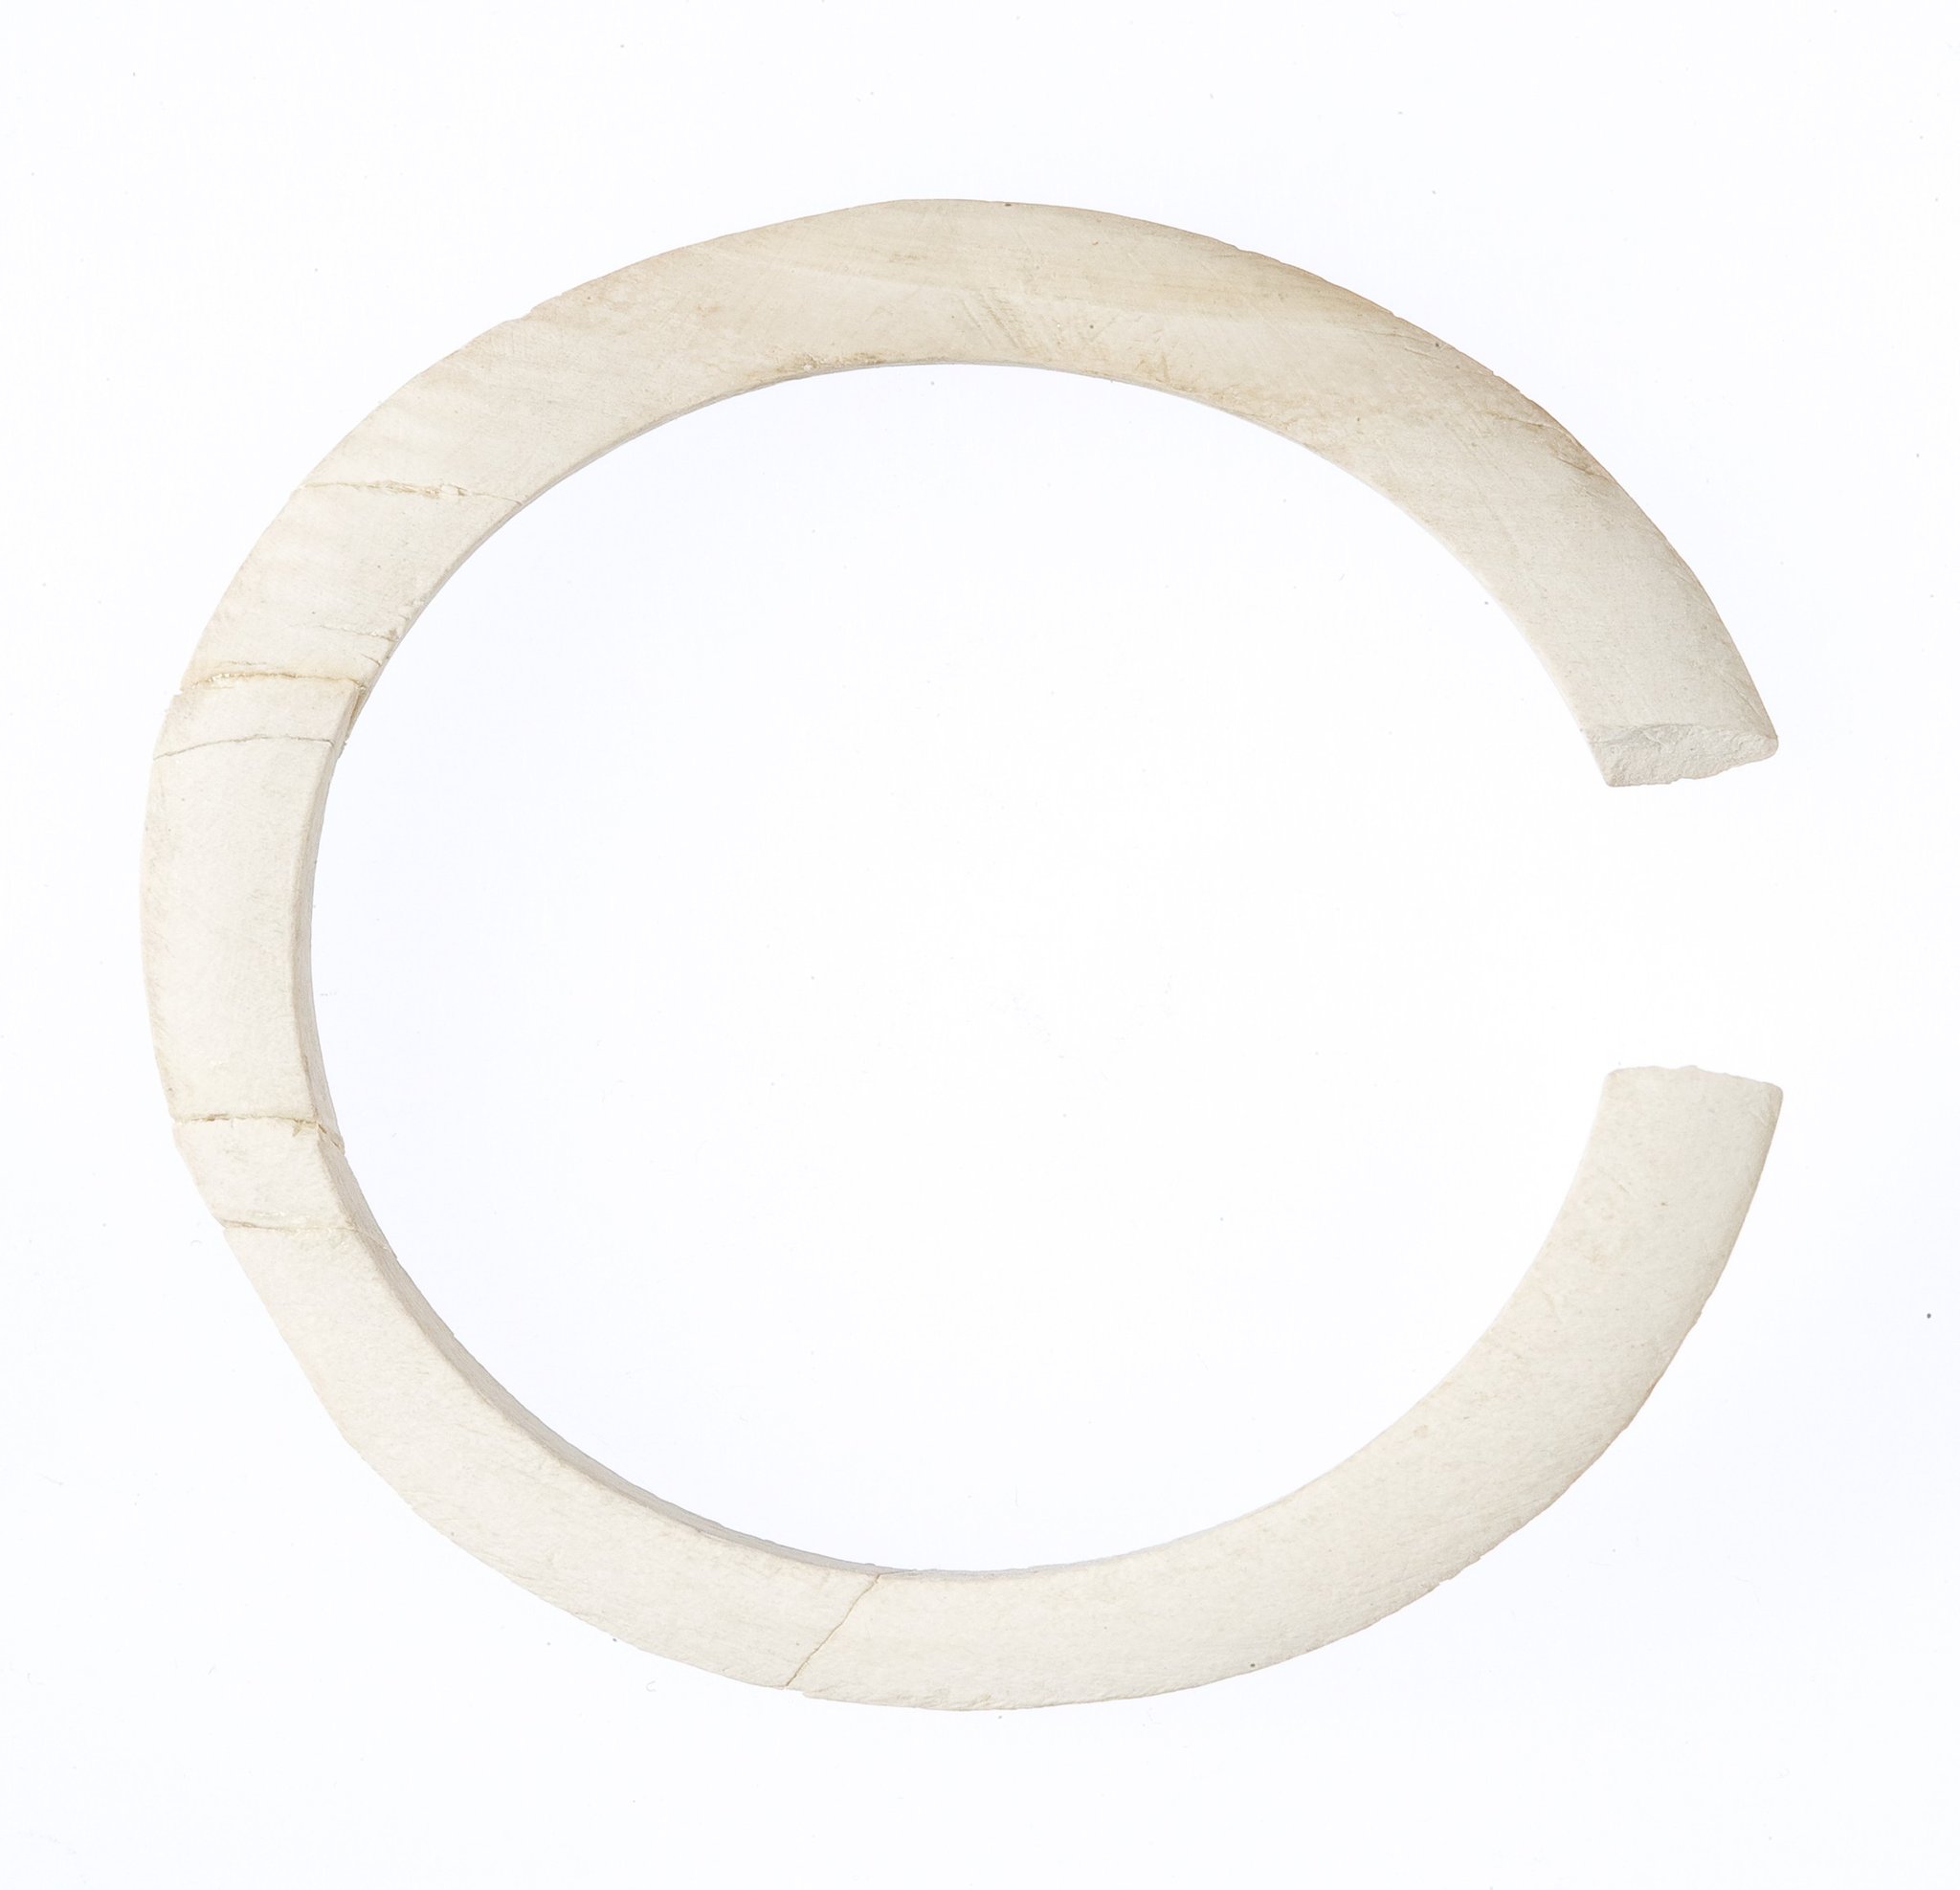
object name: bracelet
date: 1635-1458 BCE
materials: ivory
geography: egypt